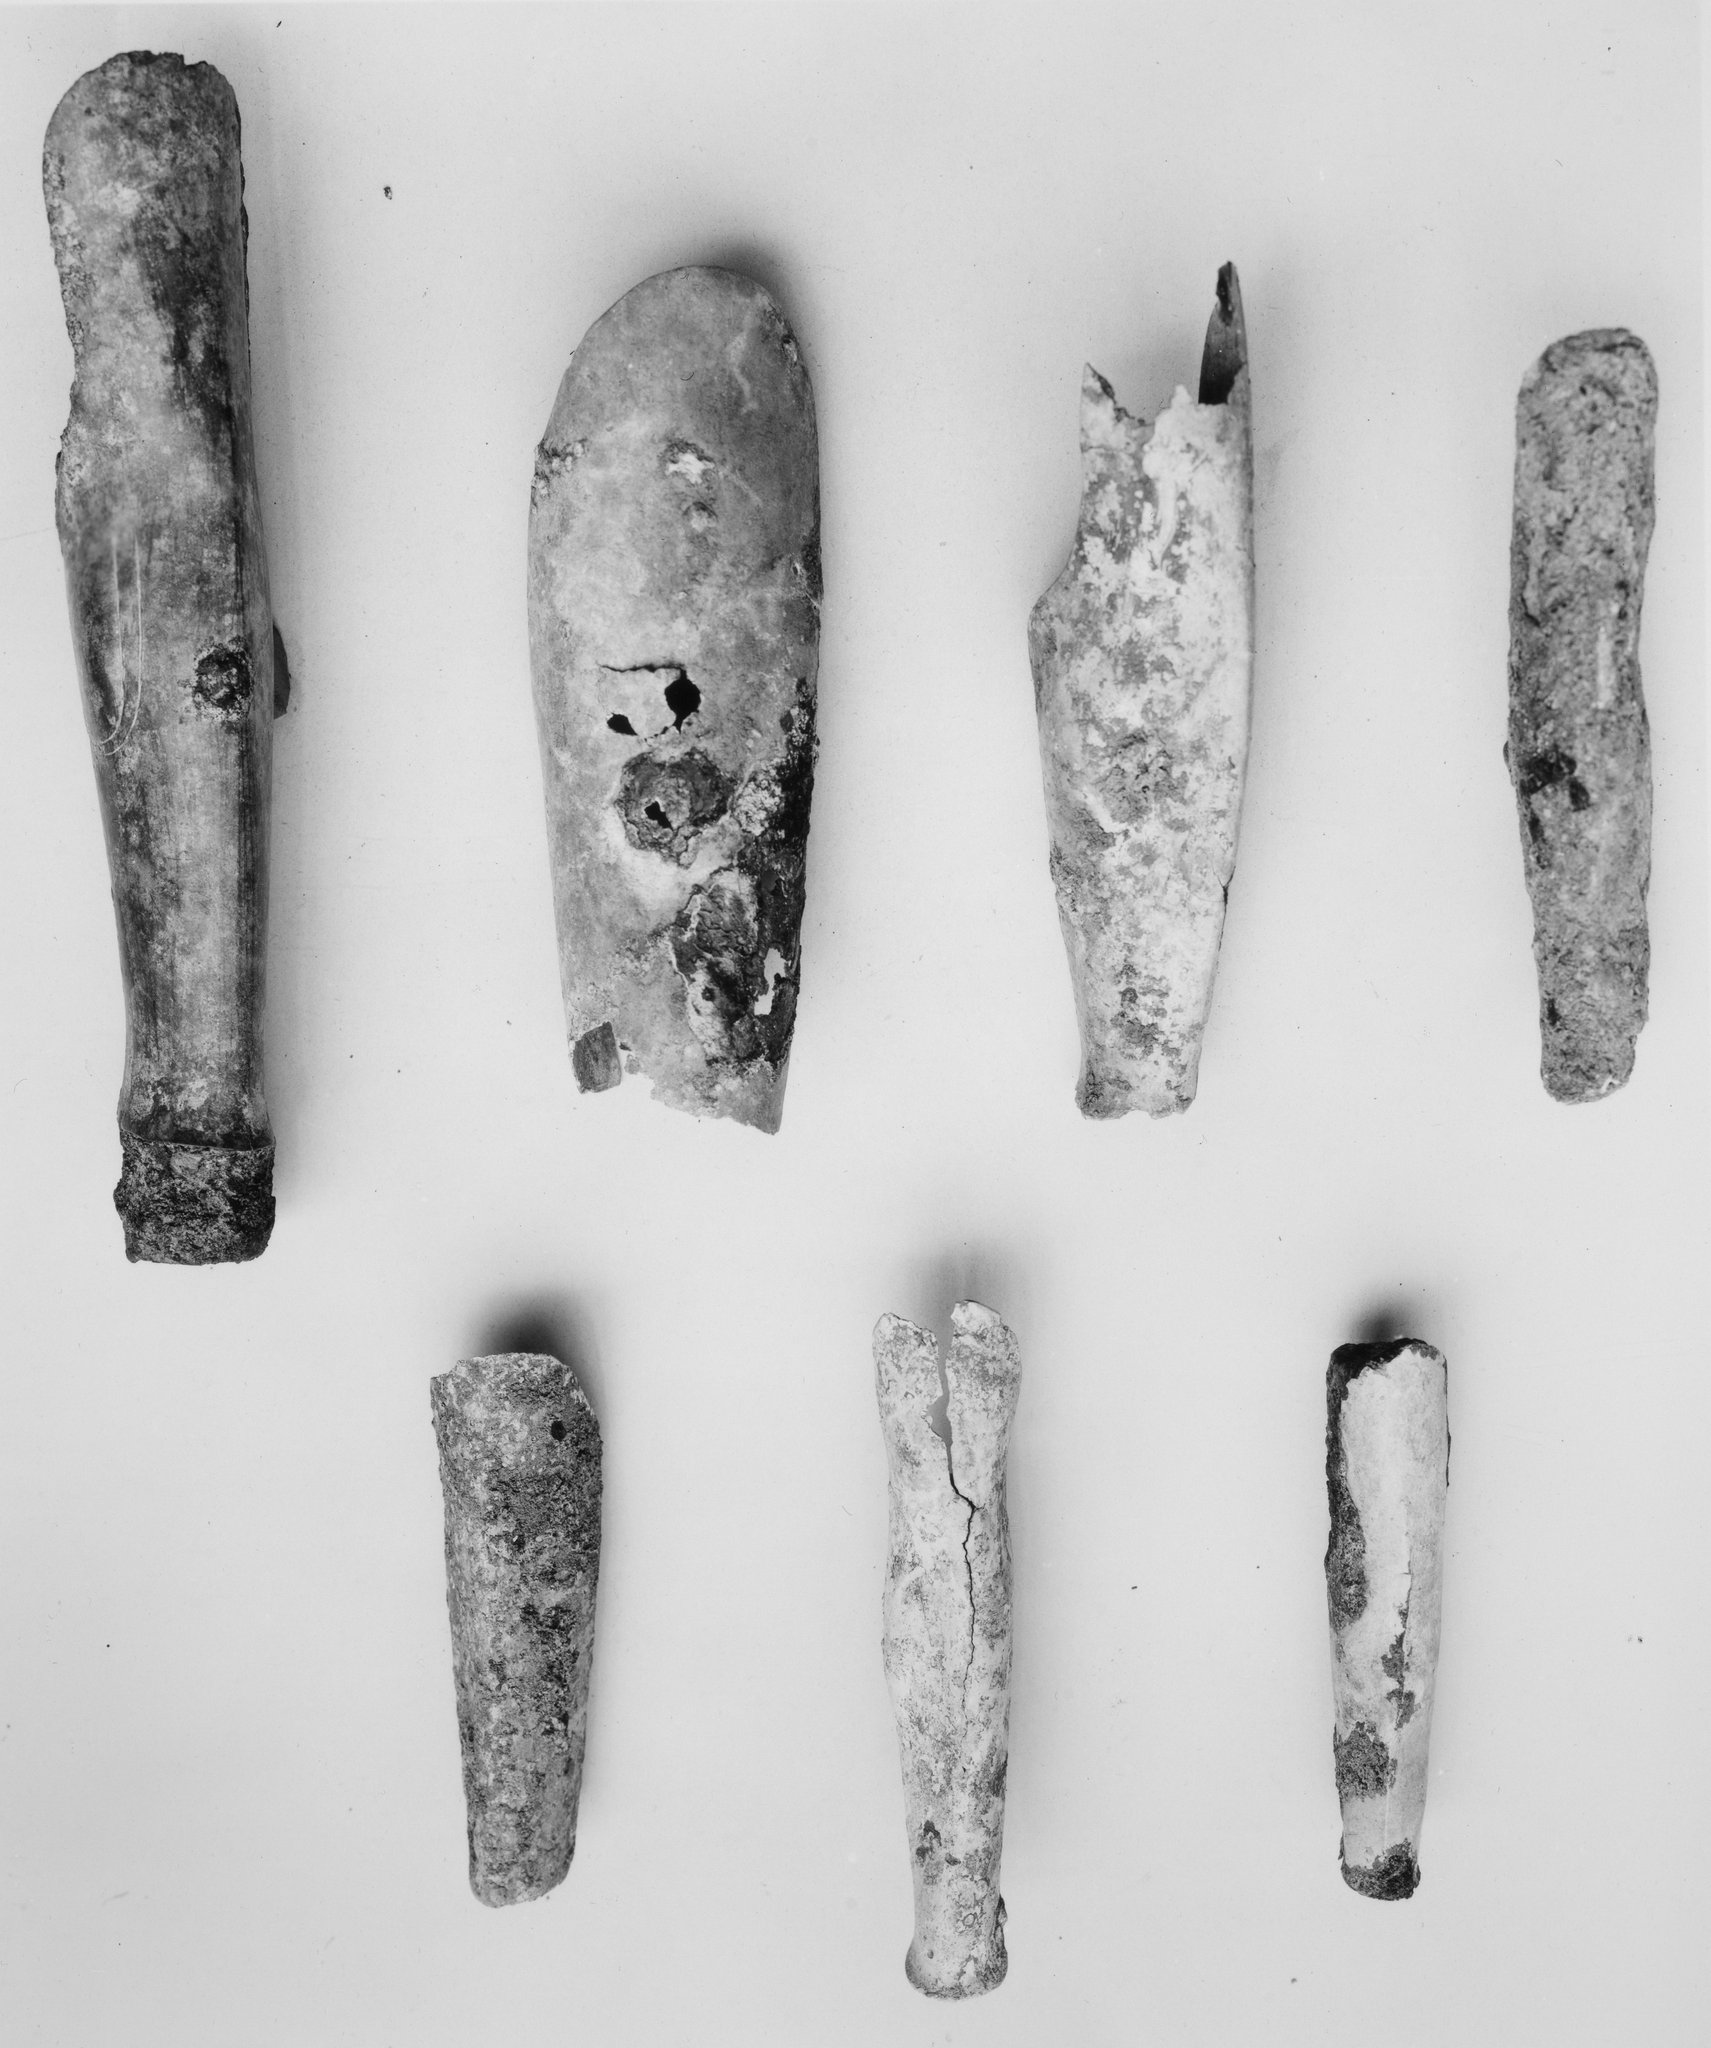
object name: greave, miniature, one of 14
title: Miniature bronze greave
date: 7000 BCE-330 CE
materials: bronze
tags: armor